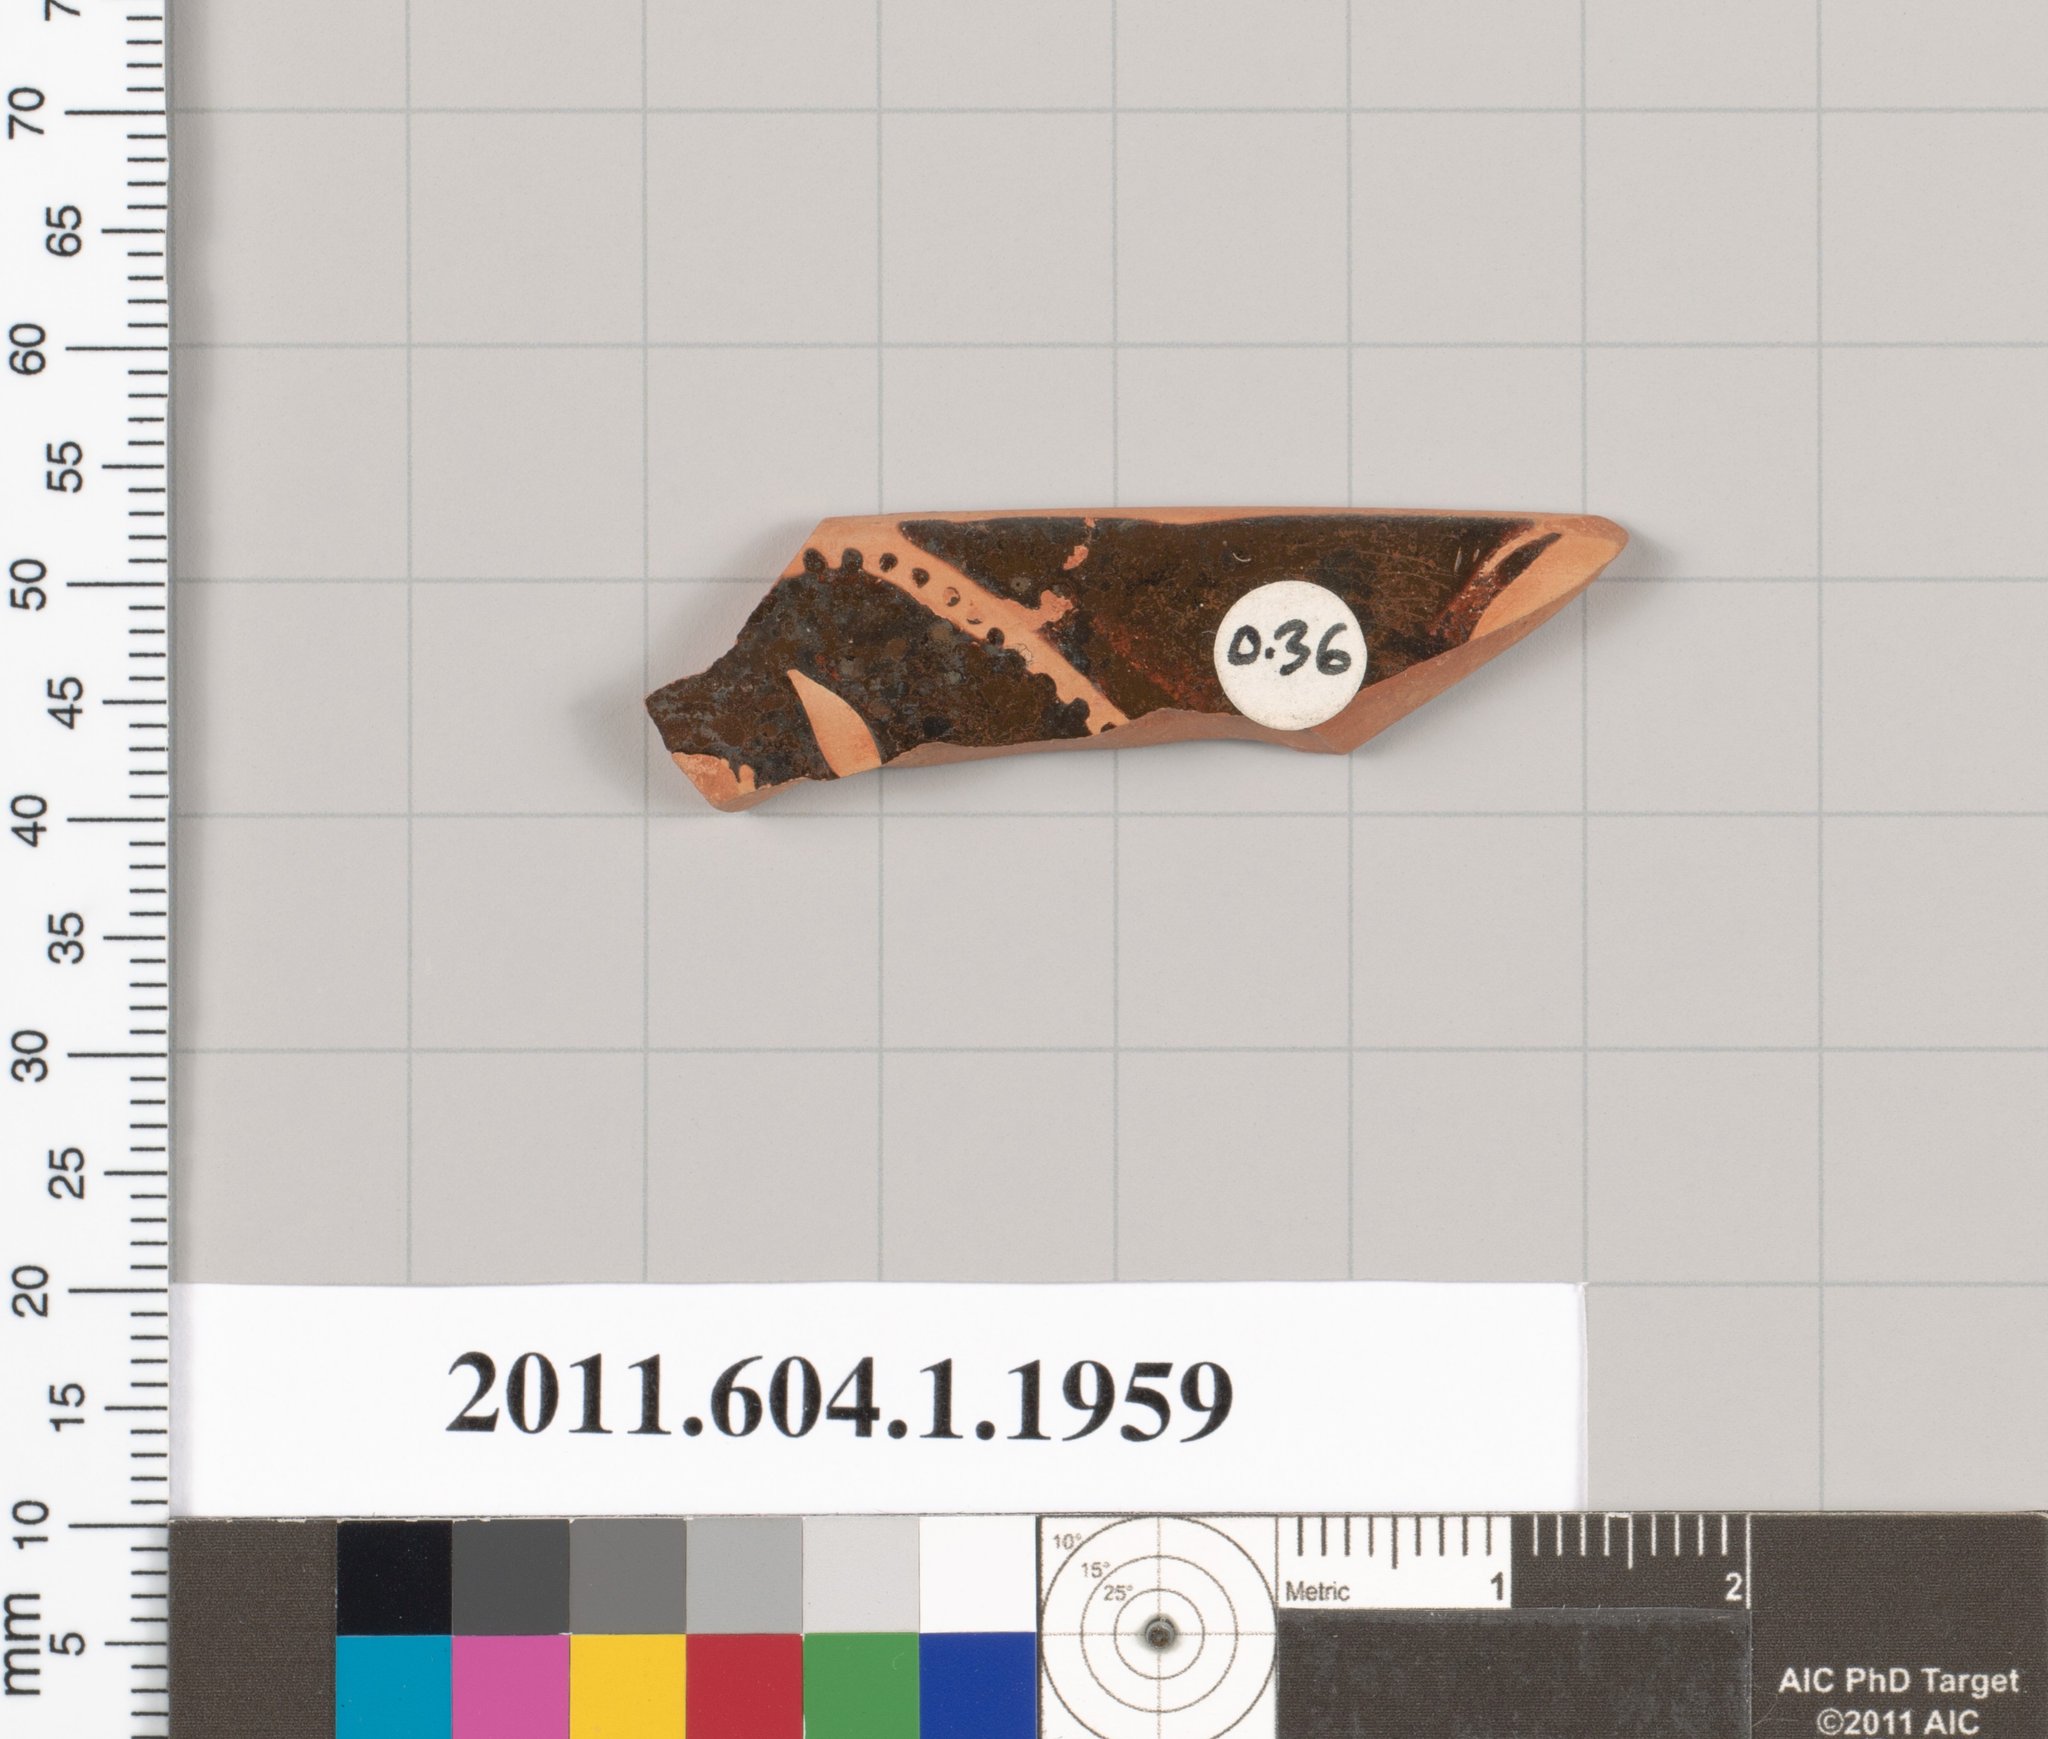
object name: kylix fragment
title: Terracotta rim fragment of a kylix (drinking cup)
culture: greek, attic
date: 534-468 BCE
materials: terracotta